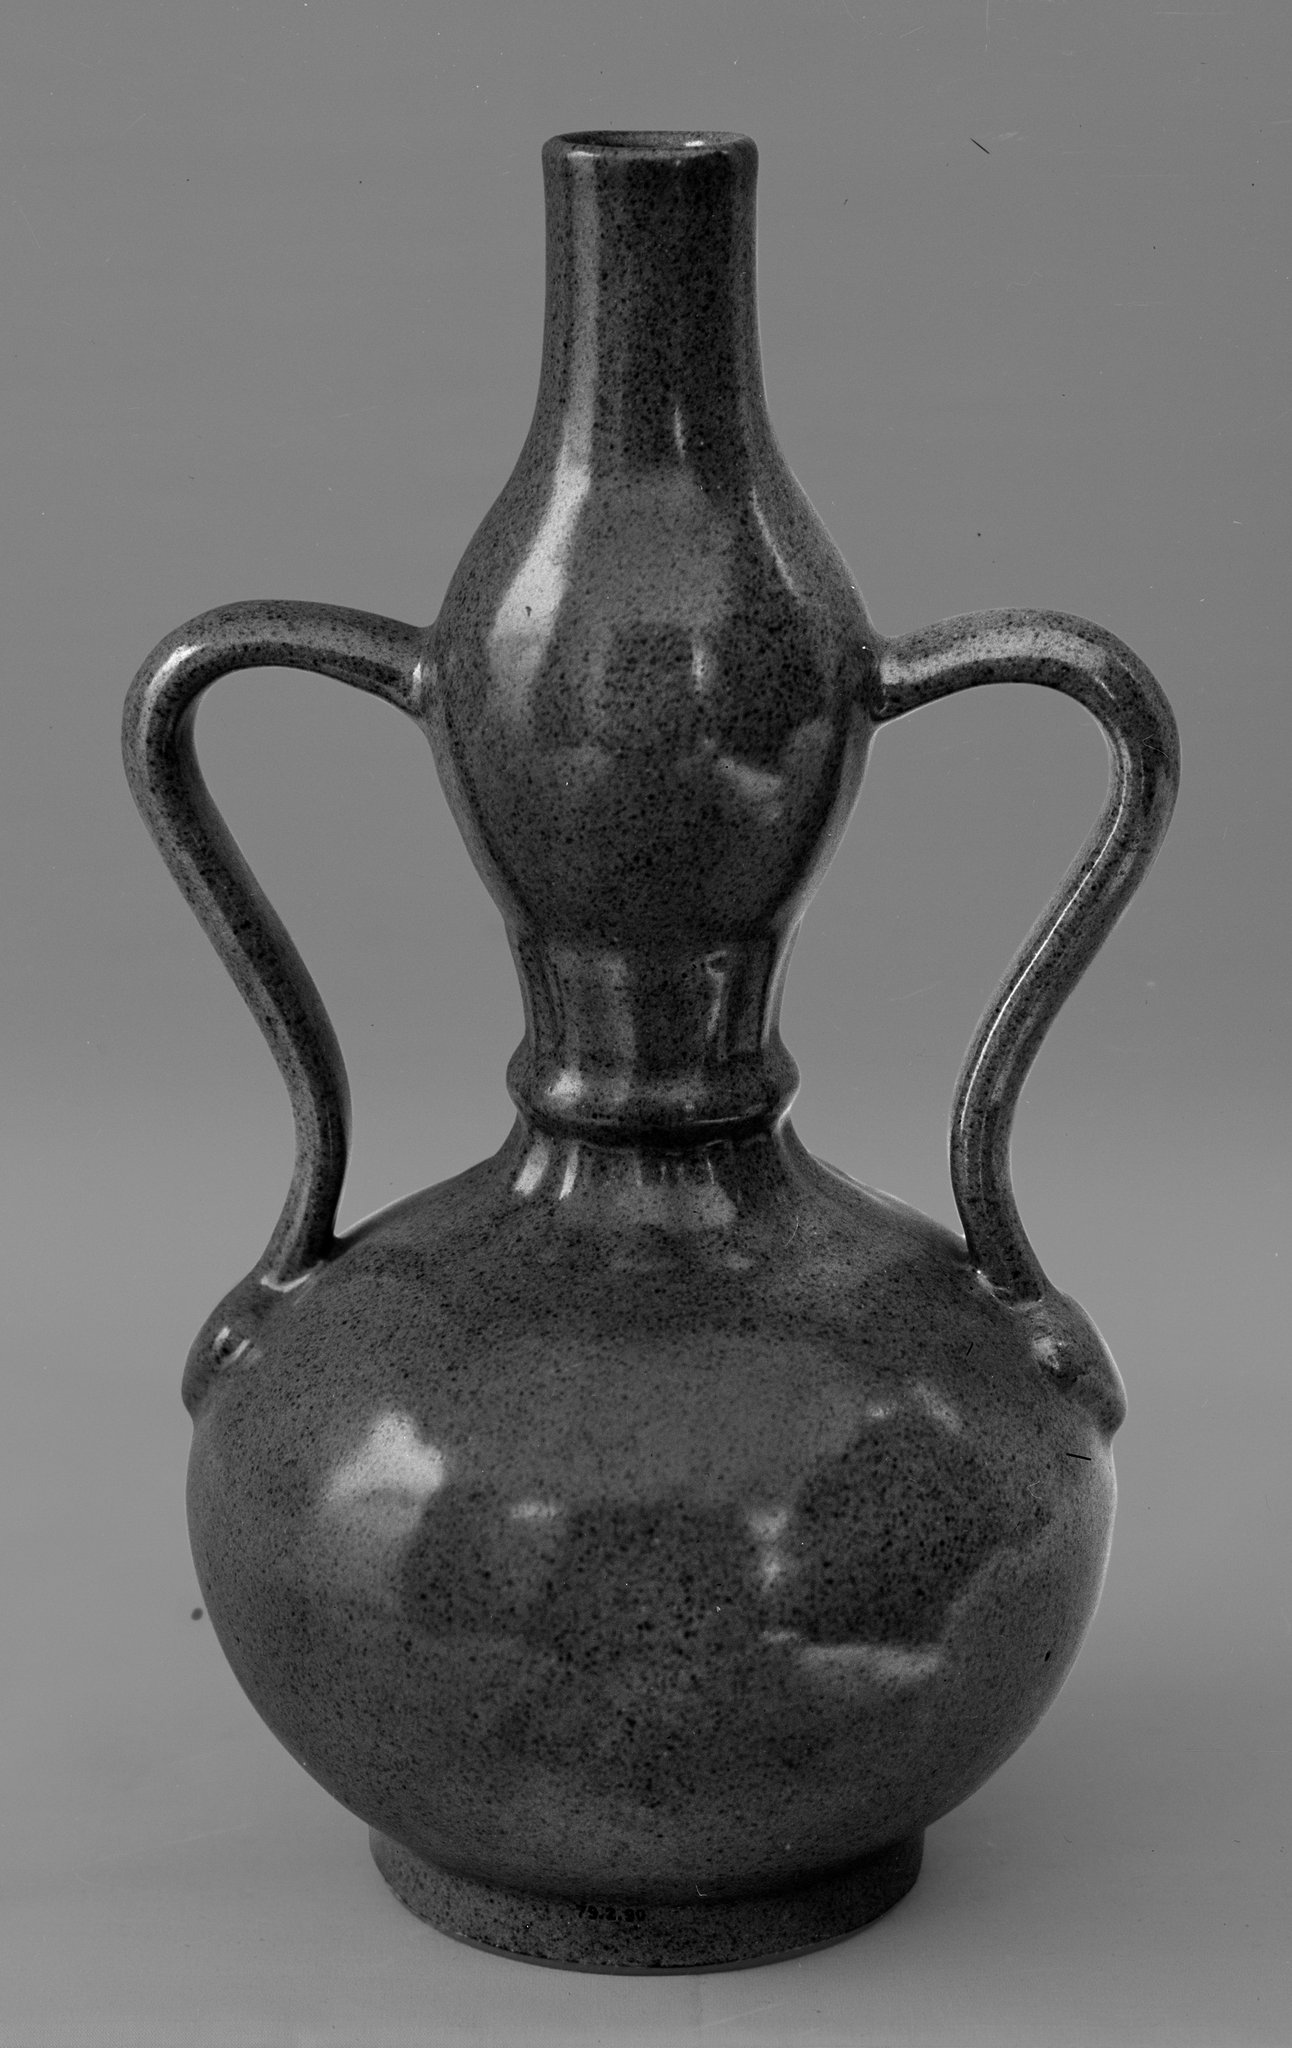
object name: vase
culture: chinese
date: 1801-1850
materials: glaze, porcelain